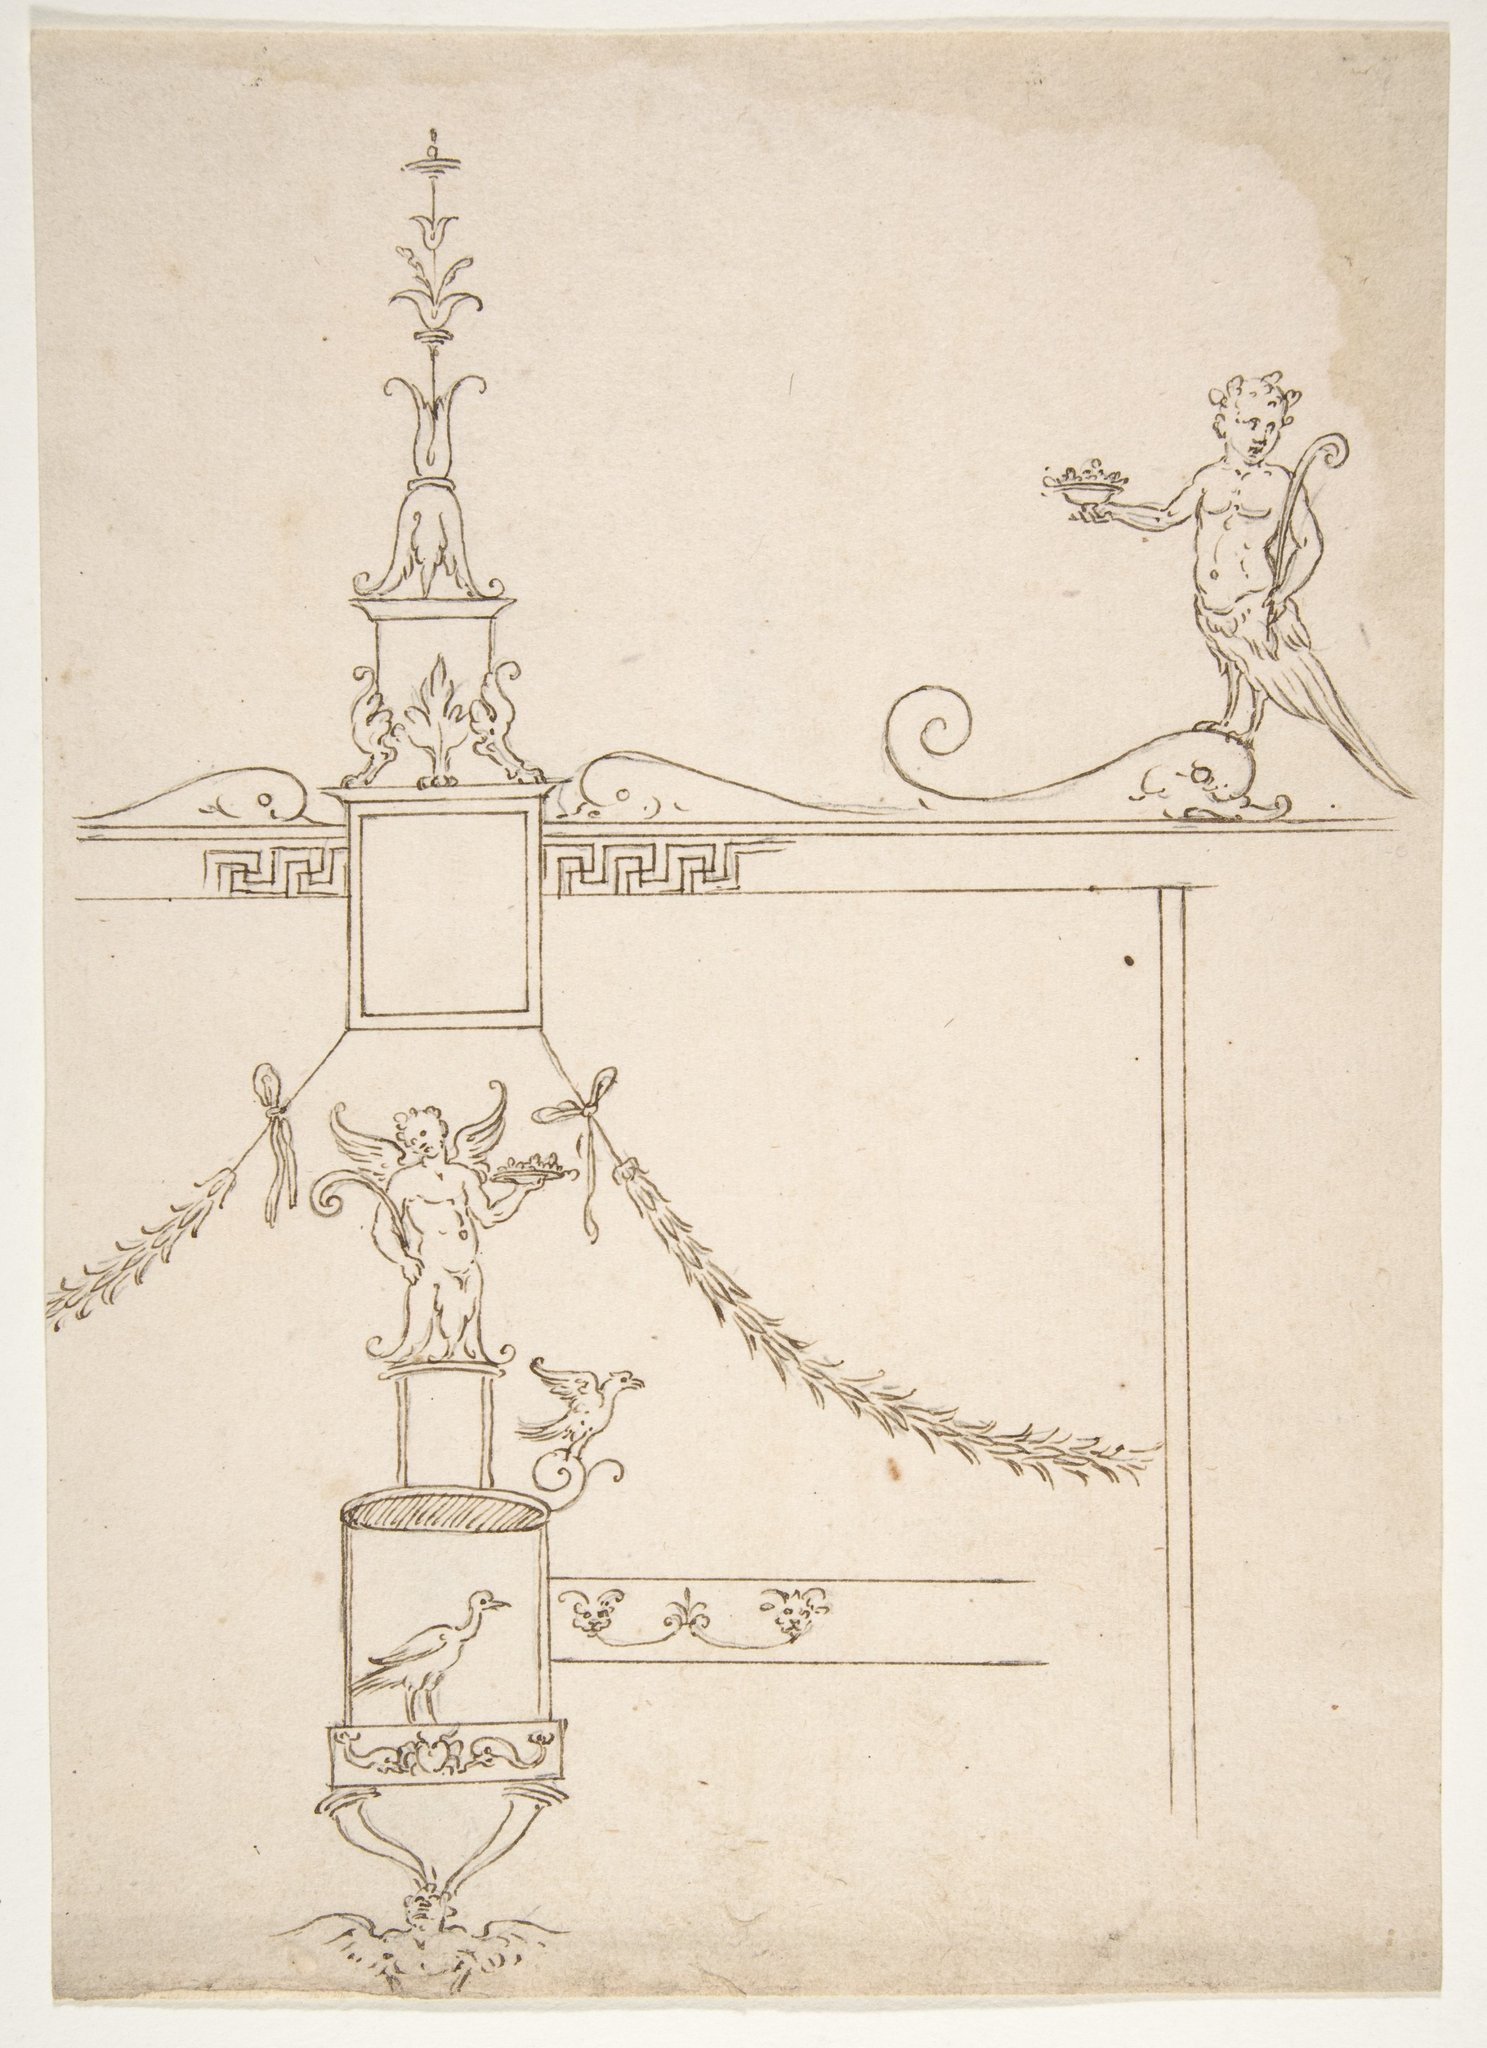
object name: collection ornament architecture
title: Domus Aurea, cryptoporticus, grotteschi, details (recto) blank (verso)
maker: anonymous, french, 16th century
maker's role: draftsman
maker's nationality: french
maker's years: 1500-1600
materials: chalk, ink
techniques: incising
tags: birds